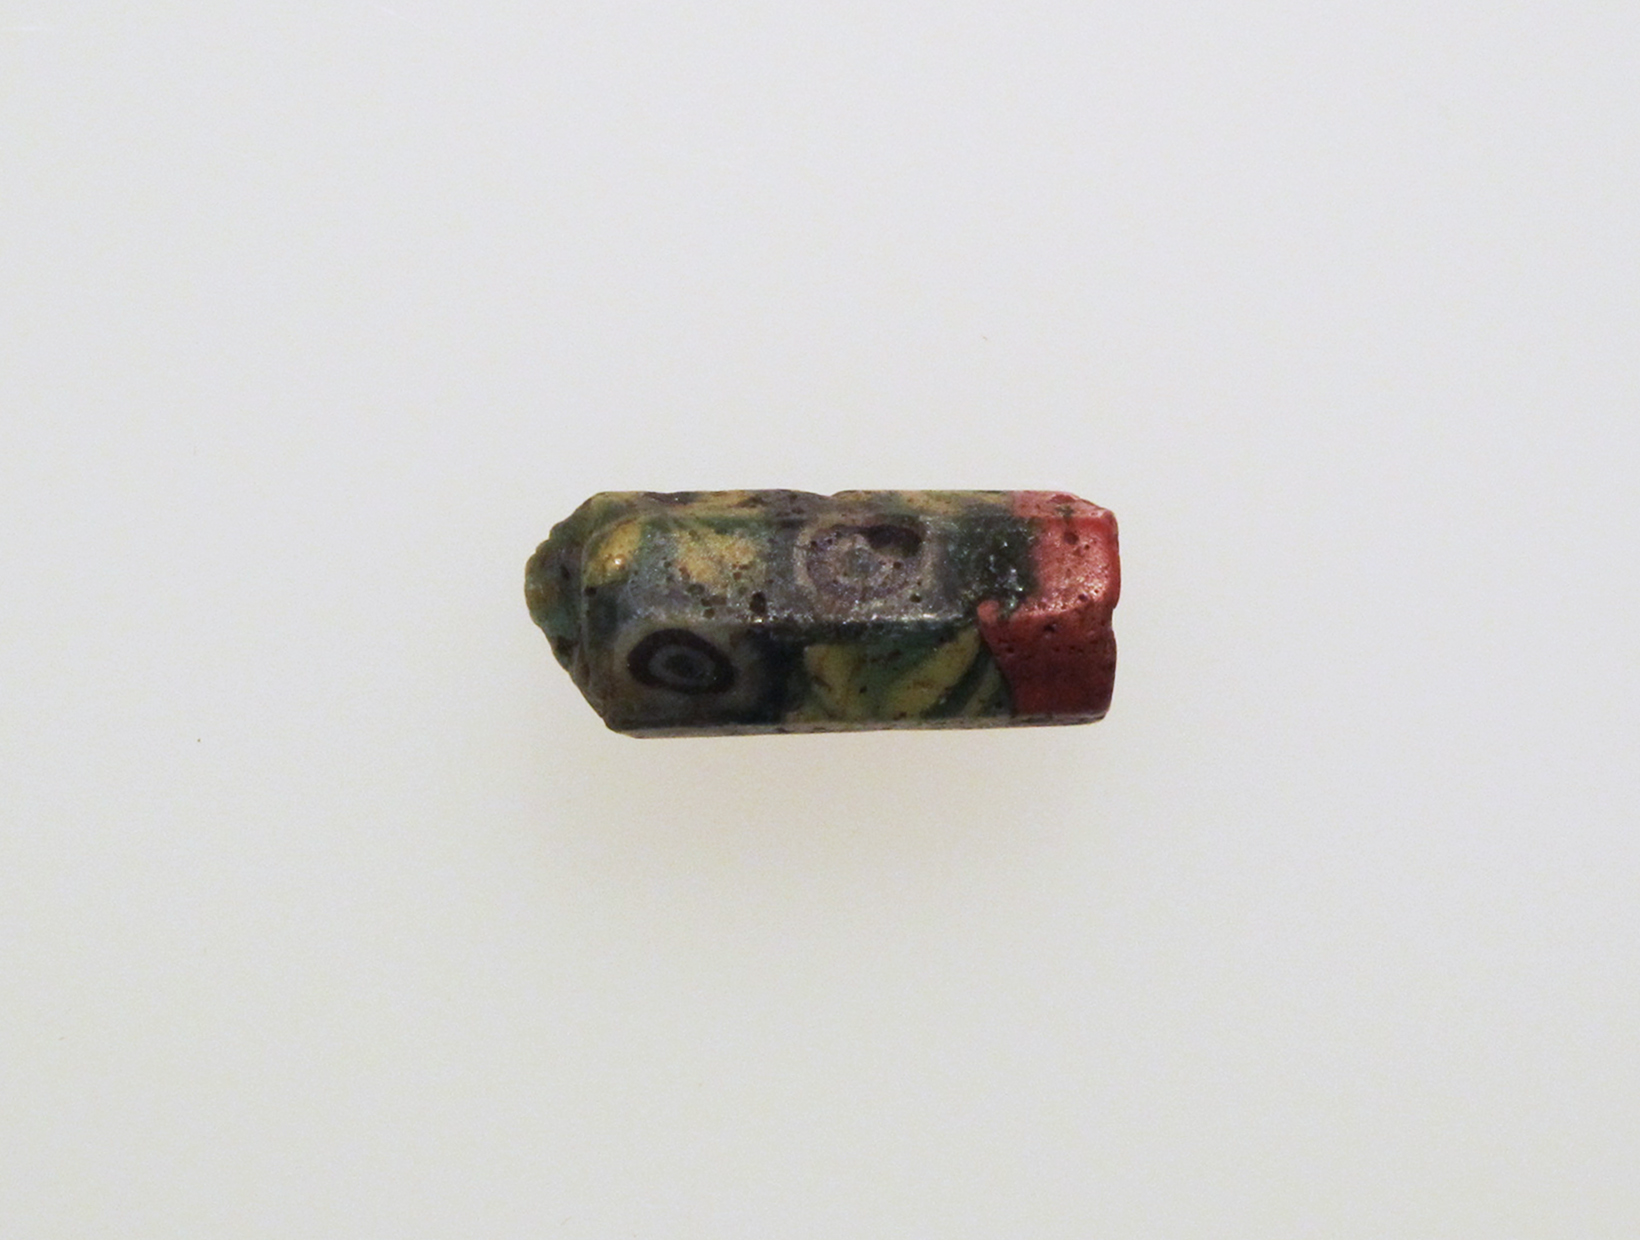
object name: millefiori bead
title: Glass mosaic bead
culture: roman, egyptian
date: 201-400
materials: glass